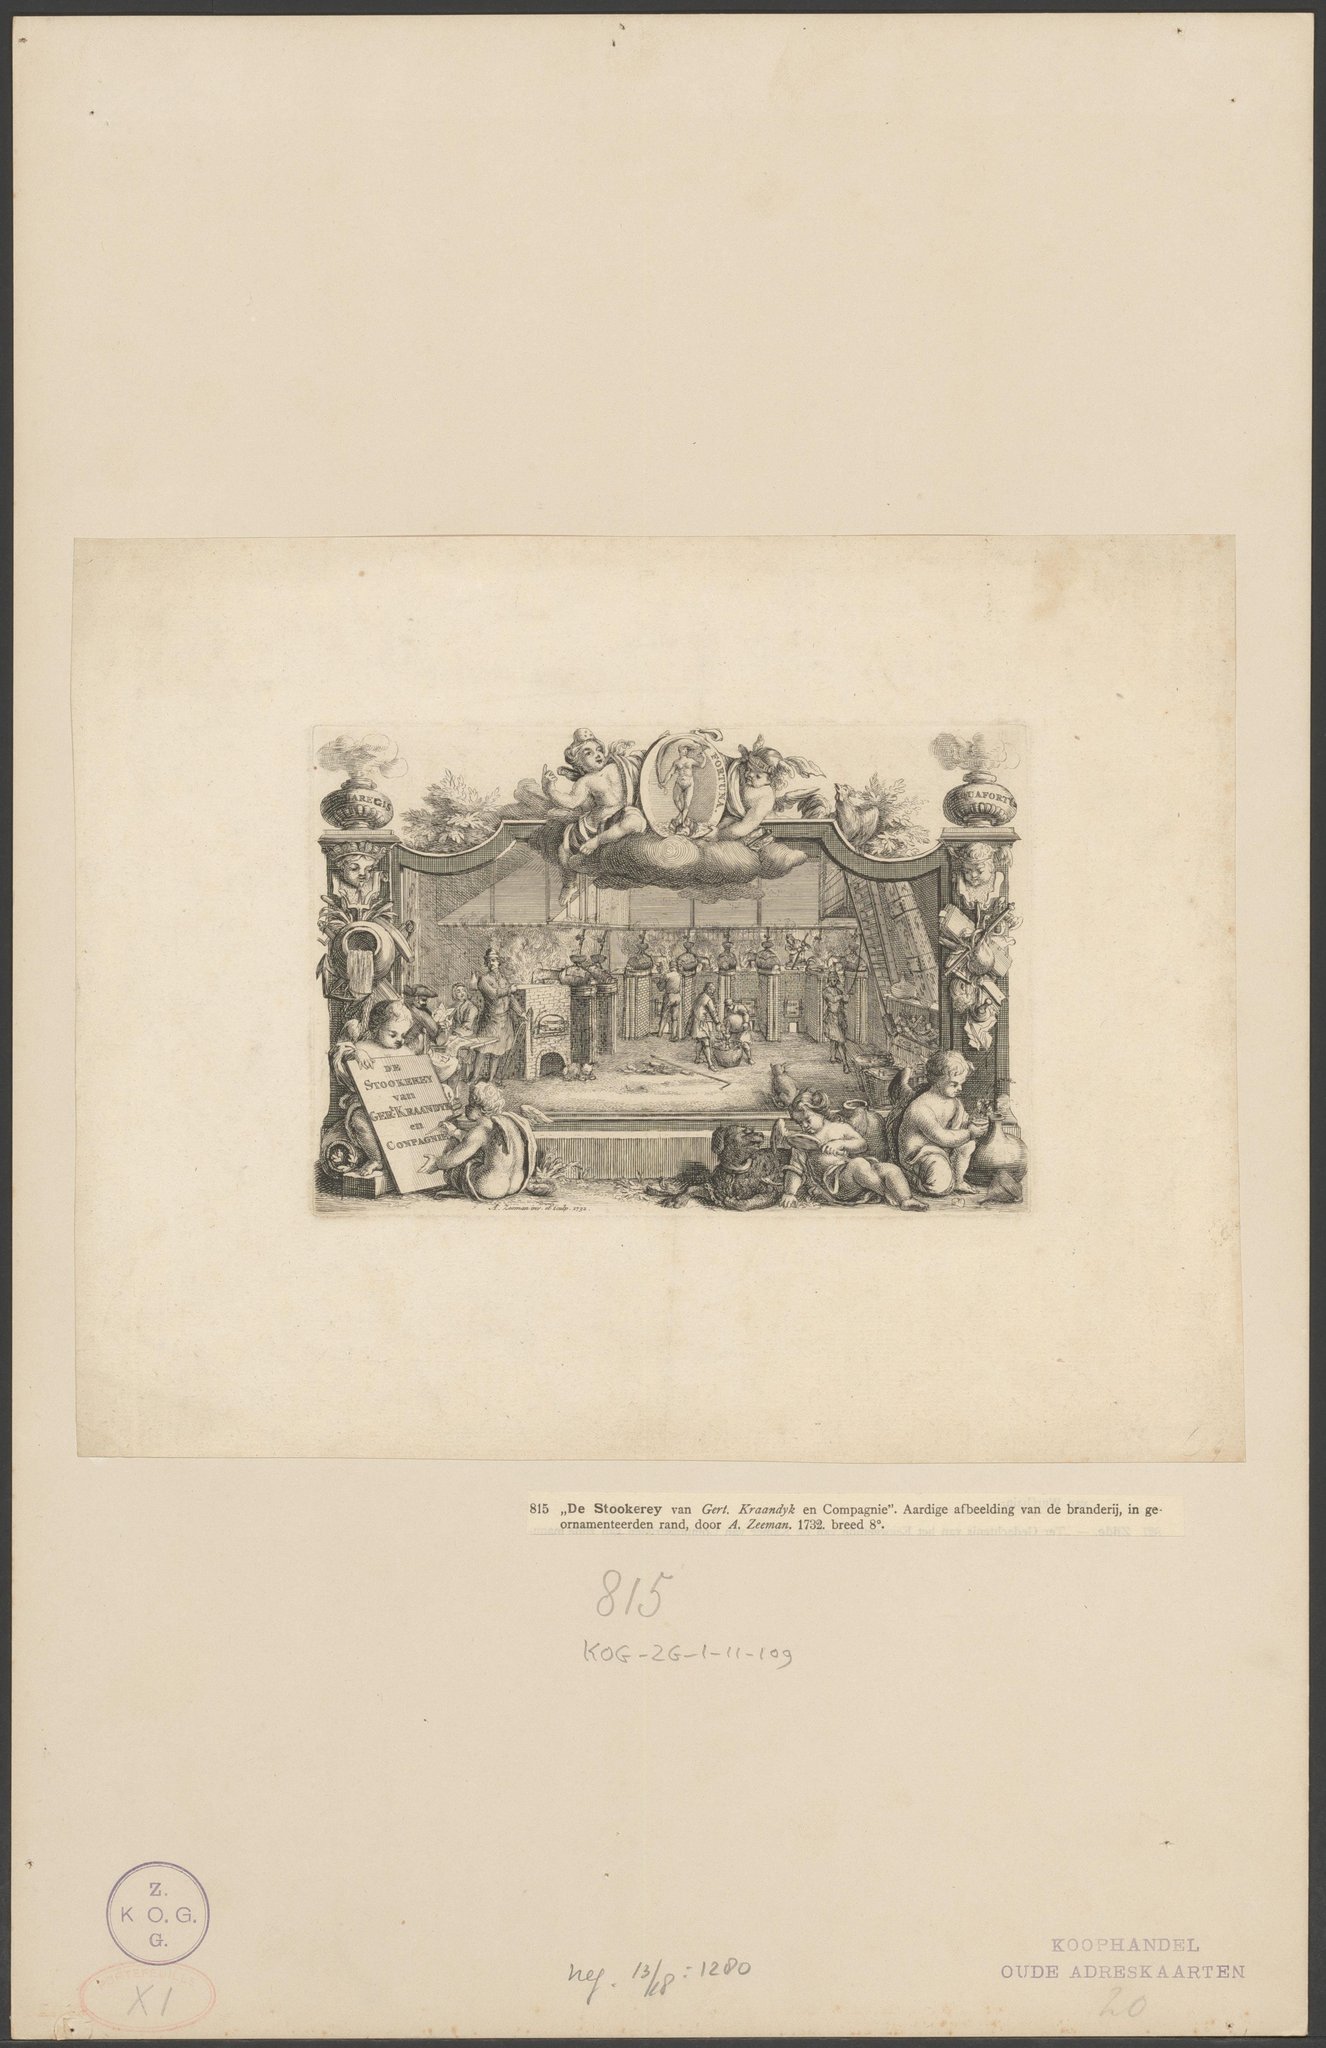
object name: business card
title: De Stookerey van Gert. Kraandyk en Conpagnie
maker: abraham zeeman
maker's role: print maker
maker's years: 1695-1754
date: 1732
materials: paper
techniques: engraving, etching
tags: brewer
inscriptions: stamp, collector's mark: Lugt 1641, stamp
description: Adreskaart van de stokerij van Gert Kraandyk en Co. In het midden een gezicht op het interieur van de stokerij. Er omheen een lijst met putti. Onderwerpsrubrieken binnen de Atlas Zeden en Gewoonten: Handel, nijverheid en verkeer, Koophandel, Veilingen, Makelaardij en Verzekeringswezen, Oude adreskaarten van winkels en fabrieken, reclame.